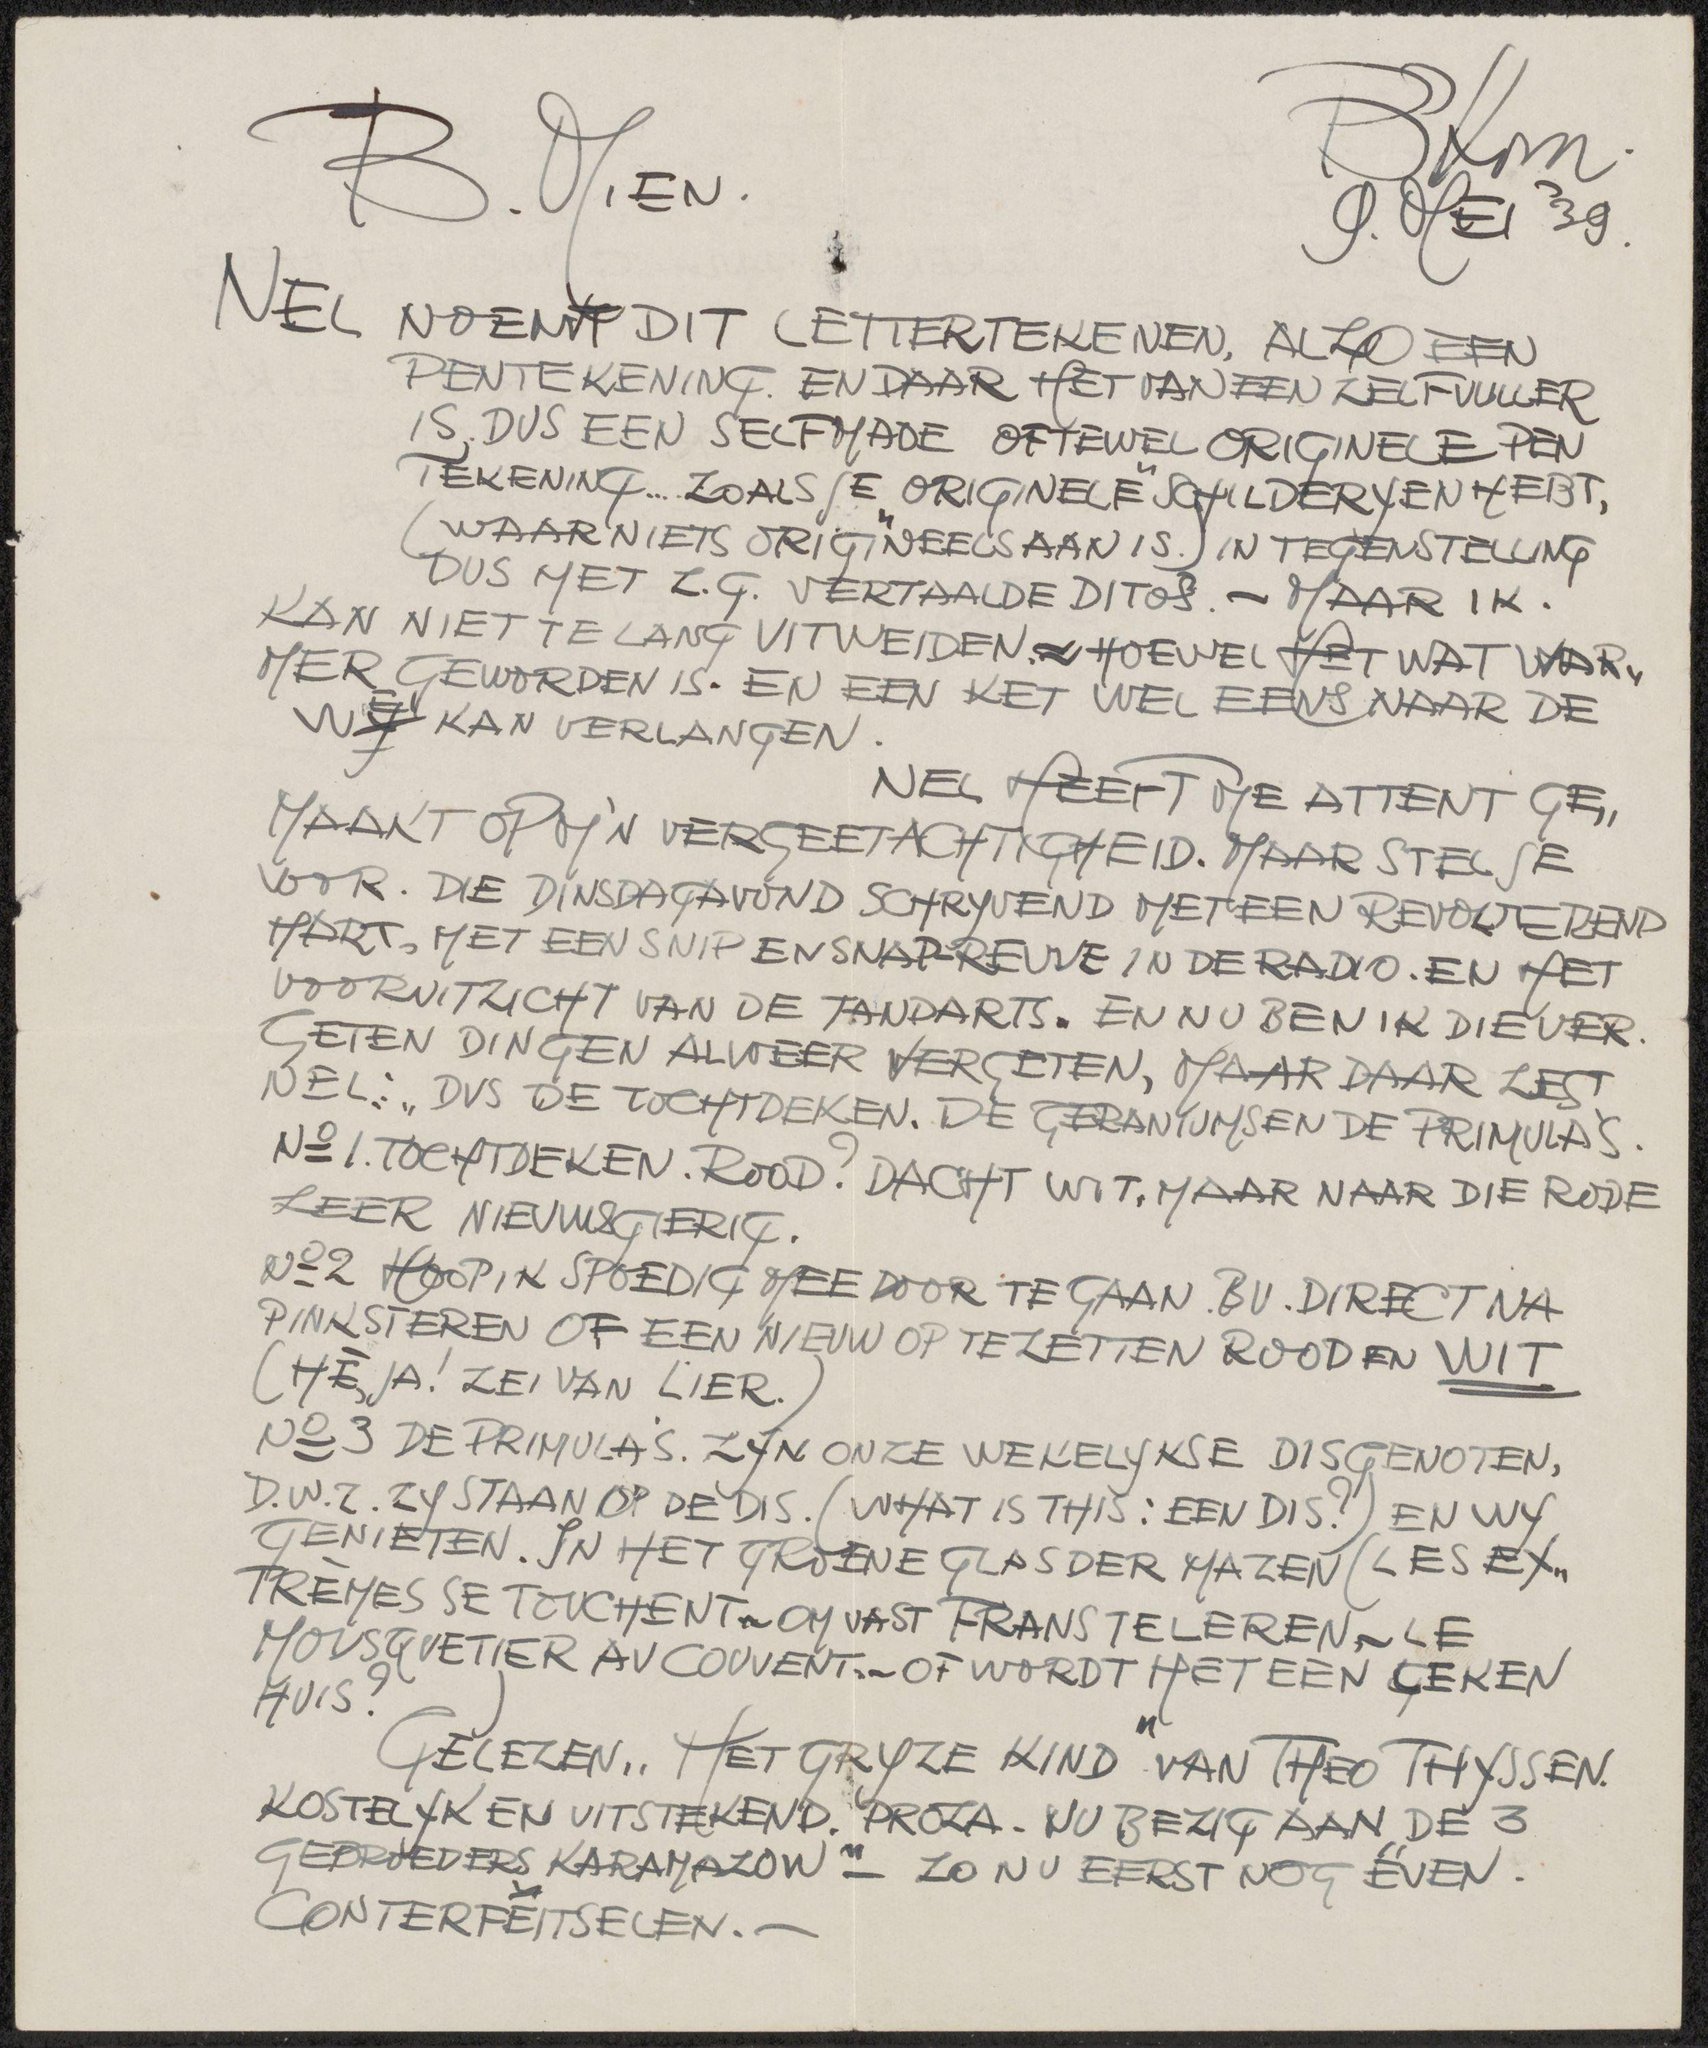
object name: letter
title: Brief aan Mien Cambier van Nooten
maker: dick ket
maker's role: draughtsman, print maker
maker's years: 1902-1940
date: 1939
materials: ink, paper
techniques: pen, writing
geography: bennekom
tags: arnhem, mien cambier van nooten, dollmaker, textile artist, nelly johanna hagelen-schilt, literature ~ arts